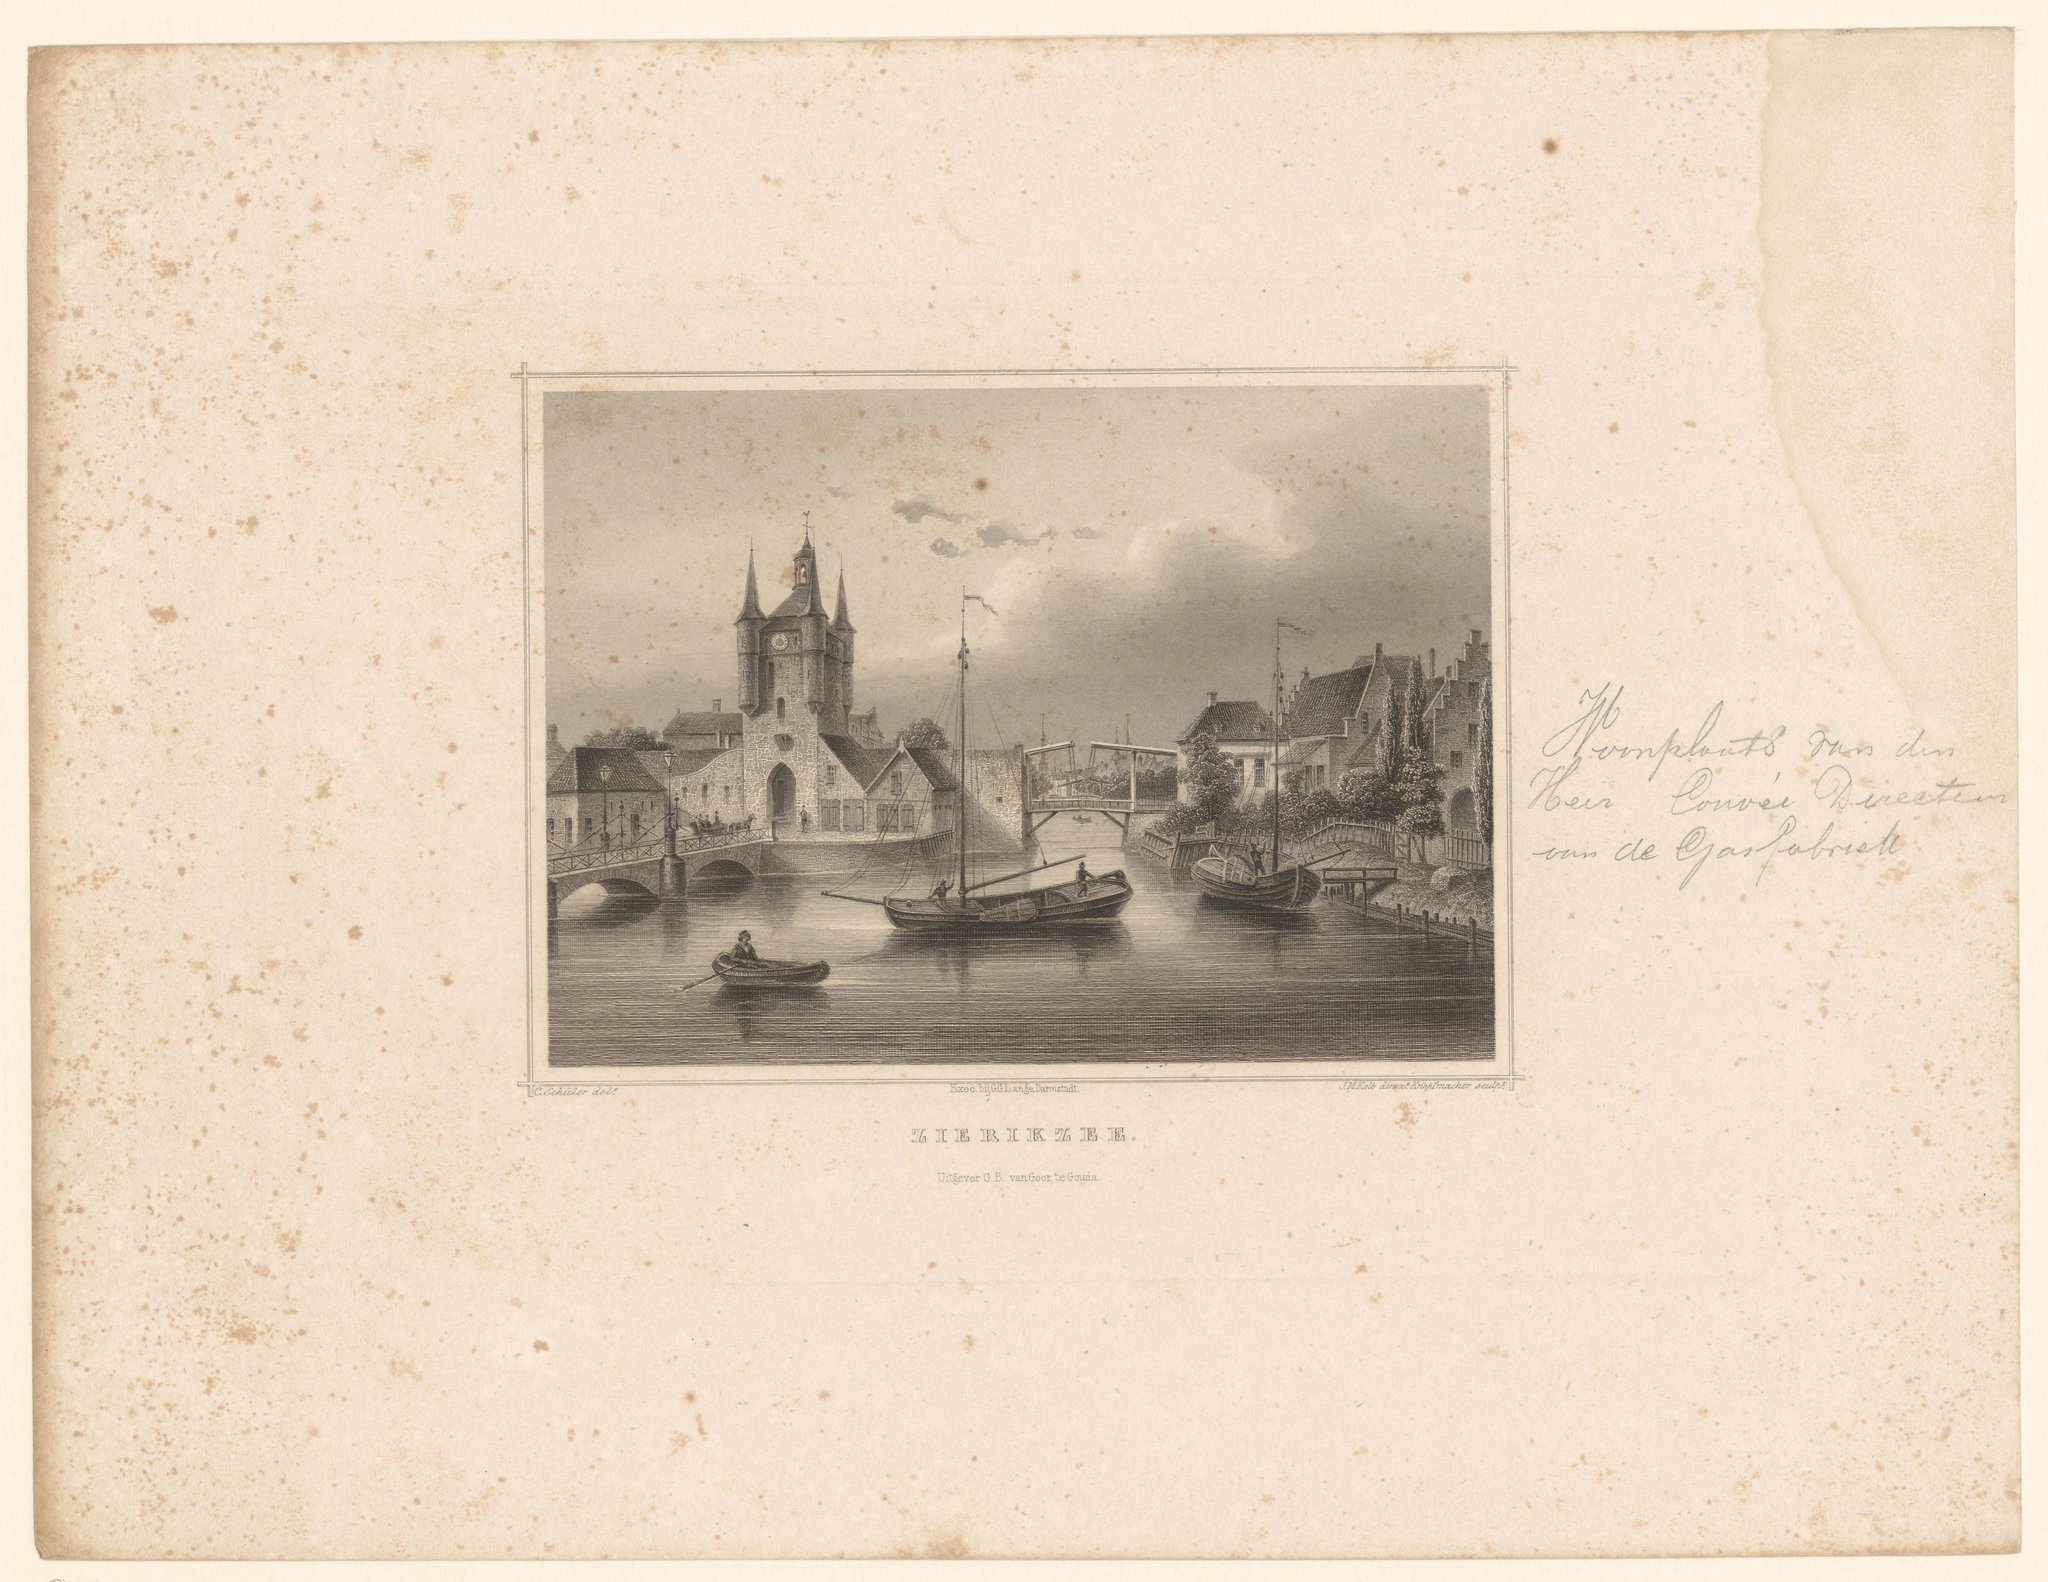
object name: print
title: Gezicht op Zierikzee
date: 1839-1871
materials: paper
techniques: engraving, etching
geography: gouda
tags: tower, clock tower ~ monumental adornment, city-view in general; 'veduta', suspension bridge, canals, waters (in city)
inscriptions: annotation: ‘Woonplaats van den Heer Couvée, Directeur van de Glasfabriek.’, collector's mark: Lugt 2228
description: Tekst in het Latijn en het Nederlands in de ondermarge.